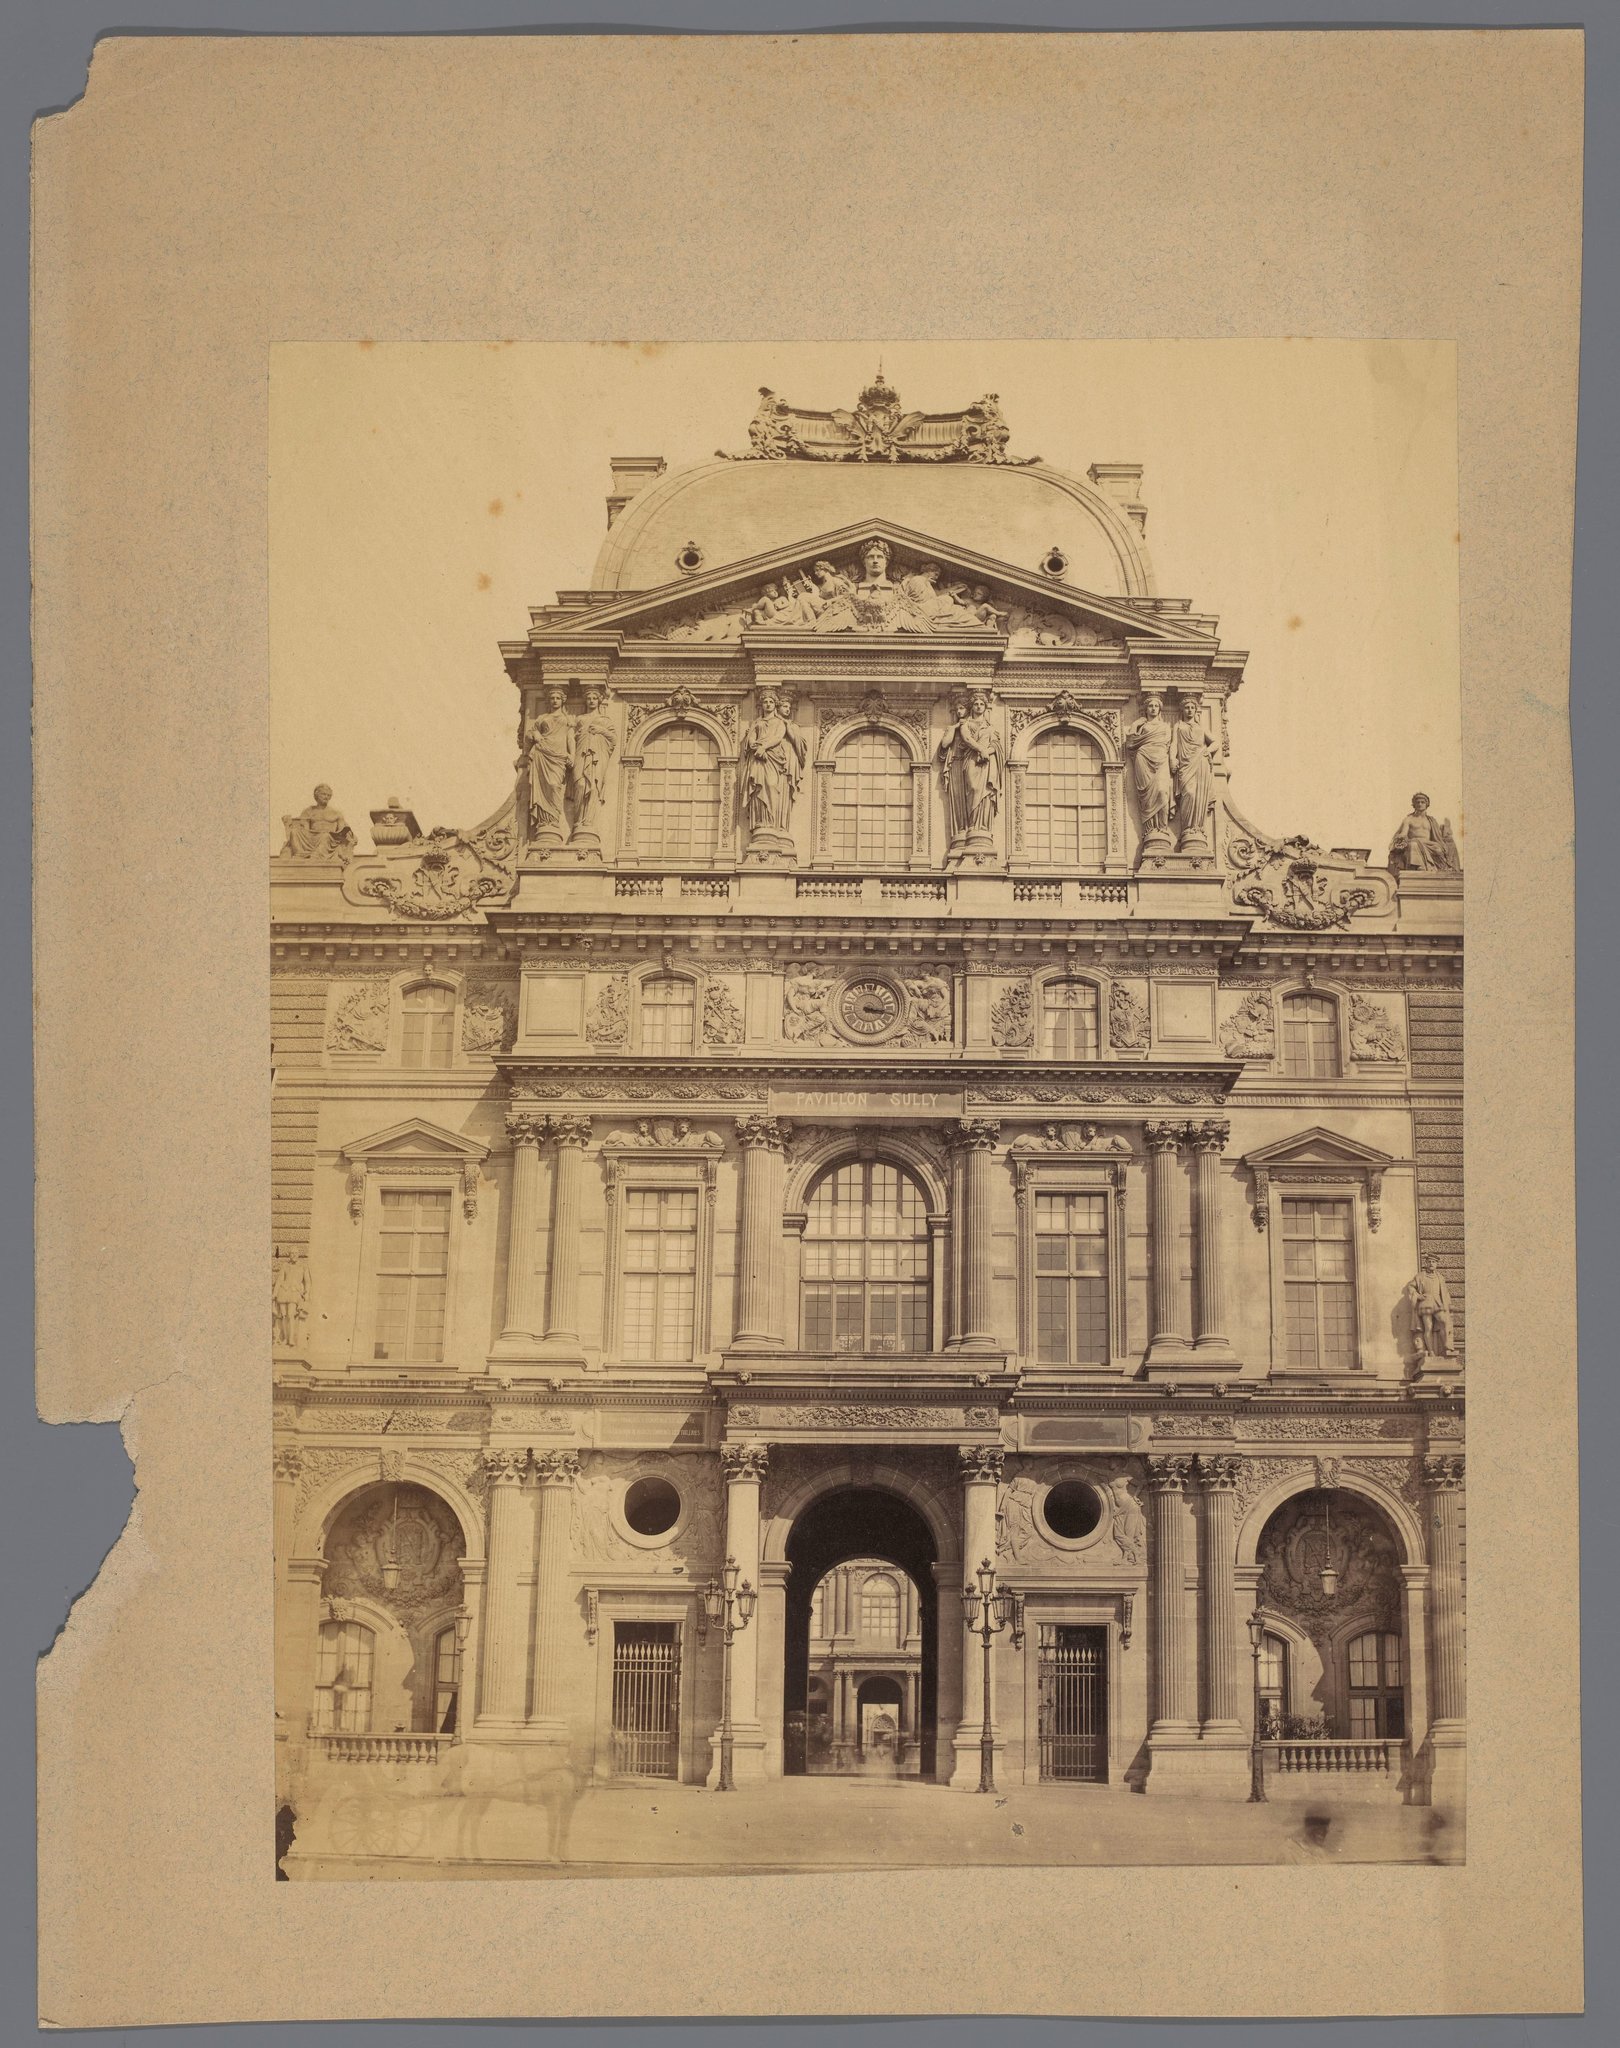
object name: photograph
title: Gezicht op het Pavillon Sully van het Louvre te Parijs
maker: Anonymous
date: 1850-1900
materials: cardboard, photographic support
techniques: albumen print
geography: paris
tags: parts of church exterior and annexes, façade (of house or building)